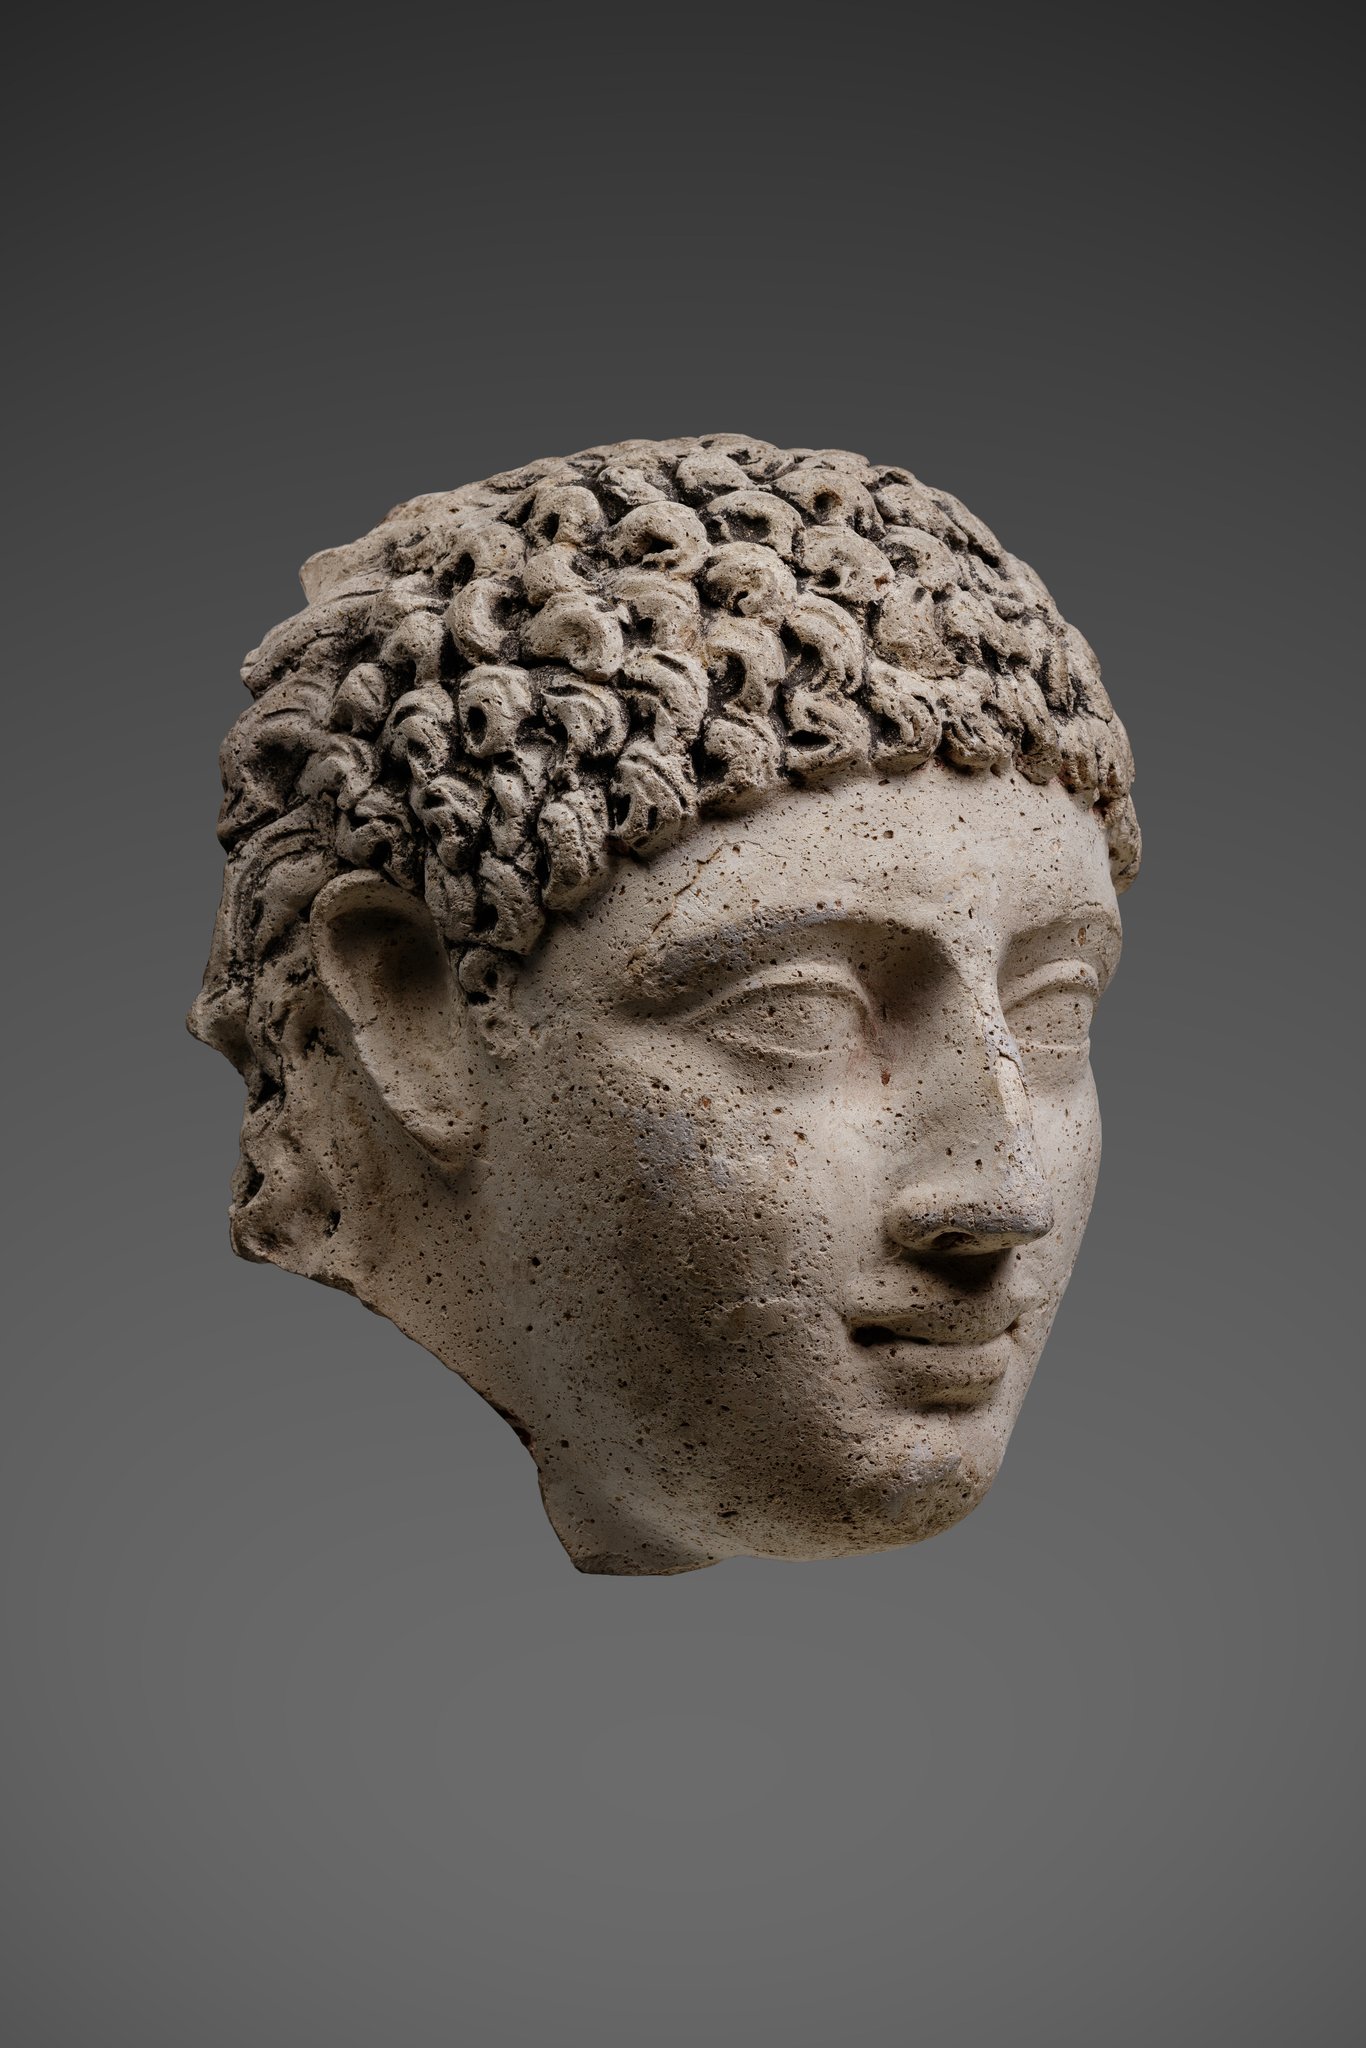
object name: mask, young person, unusual hairstyle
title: Mask of a young person with an unusual hairstyle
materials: paint, plaster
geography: egypt